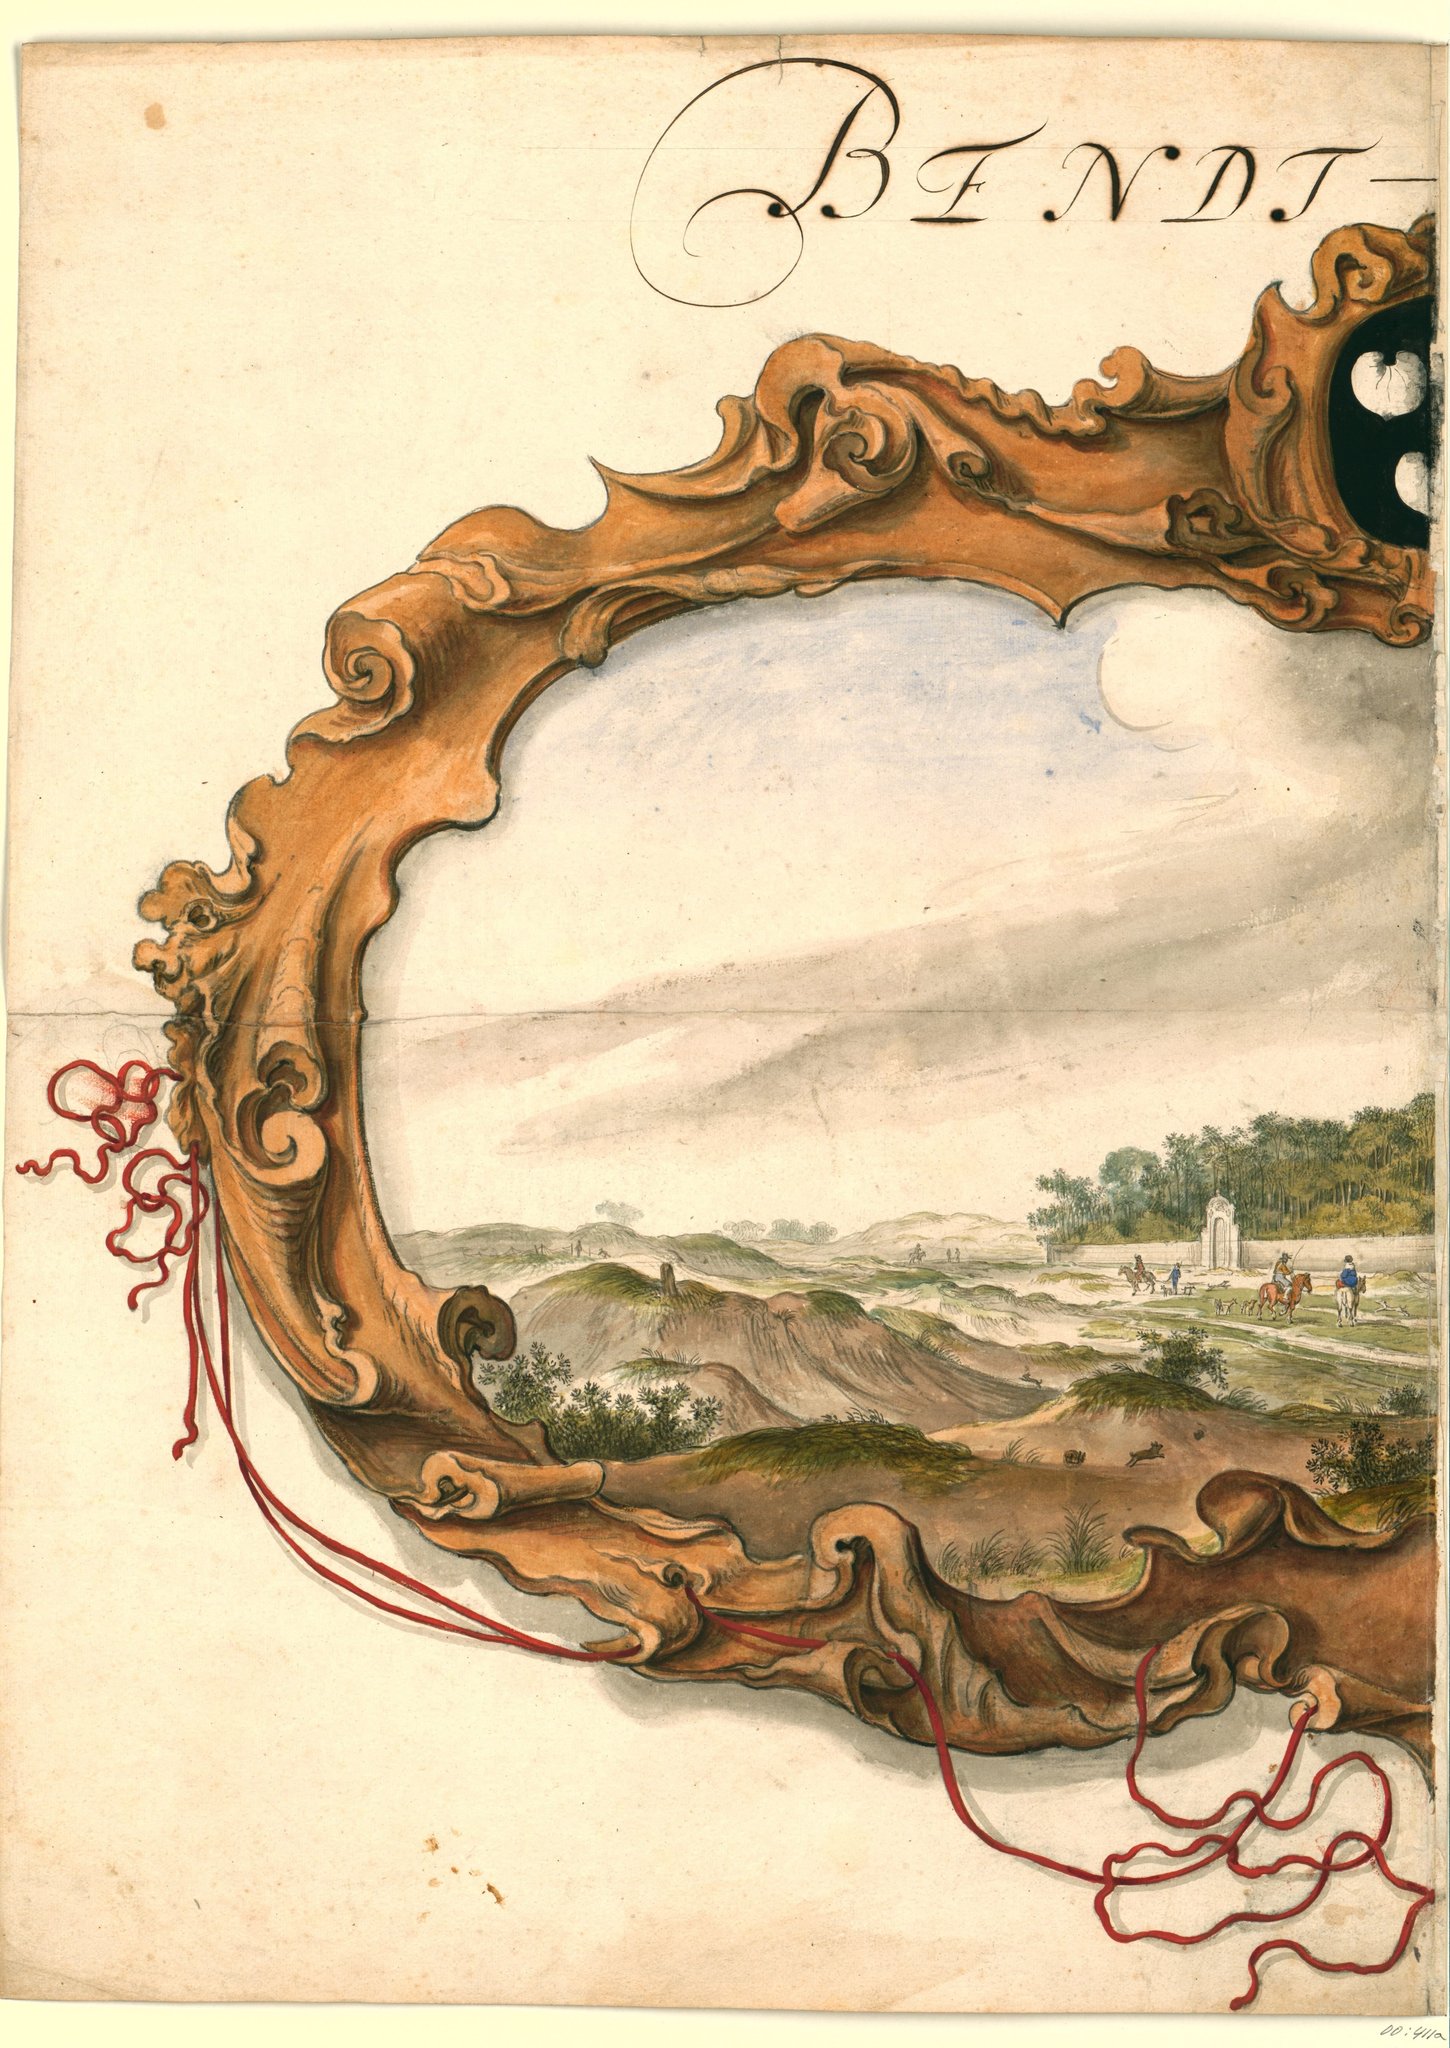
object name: drawing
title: Cartouche met gezicht op het buitengoed Bentveld (linkerblad)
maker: Anonymous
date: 1600-1699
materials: chalk, ink, paper, watercolor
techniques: brush, pen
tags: dunes (sea not visible); in the dunes, rural housing, e.g. country-house, villa, cottage, ornament ~ cartouche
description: Linkerblad van voorstelling op twee bladen met een gezicht op Bentveld (rechterblad heeft objectnummer RP-T-00-411B).